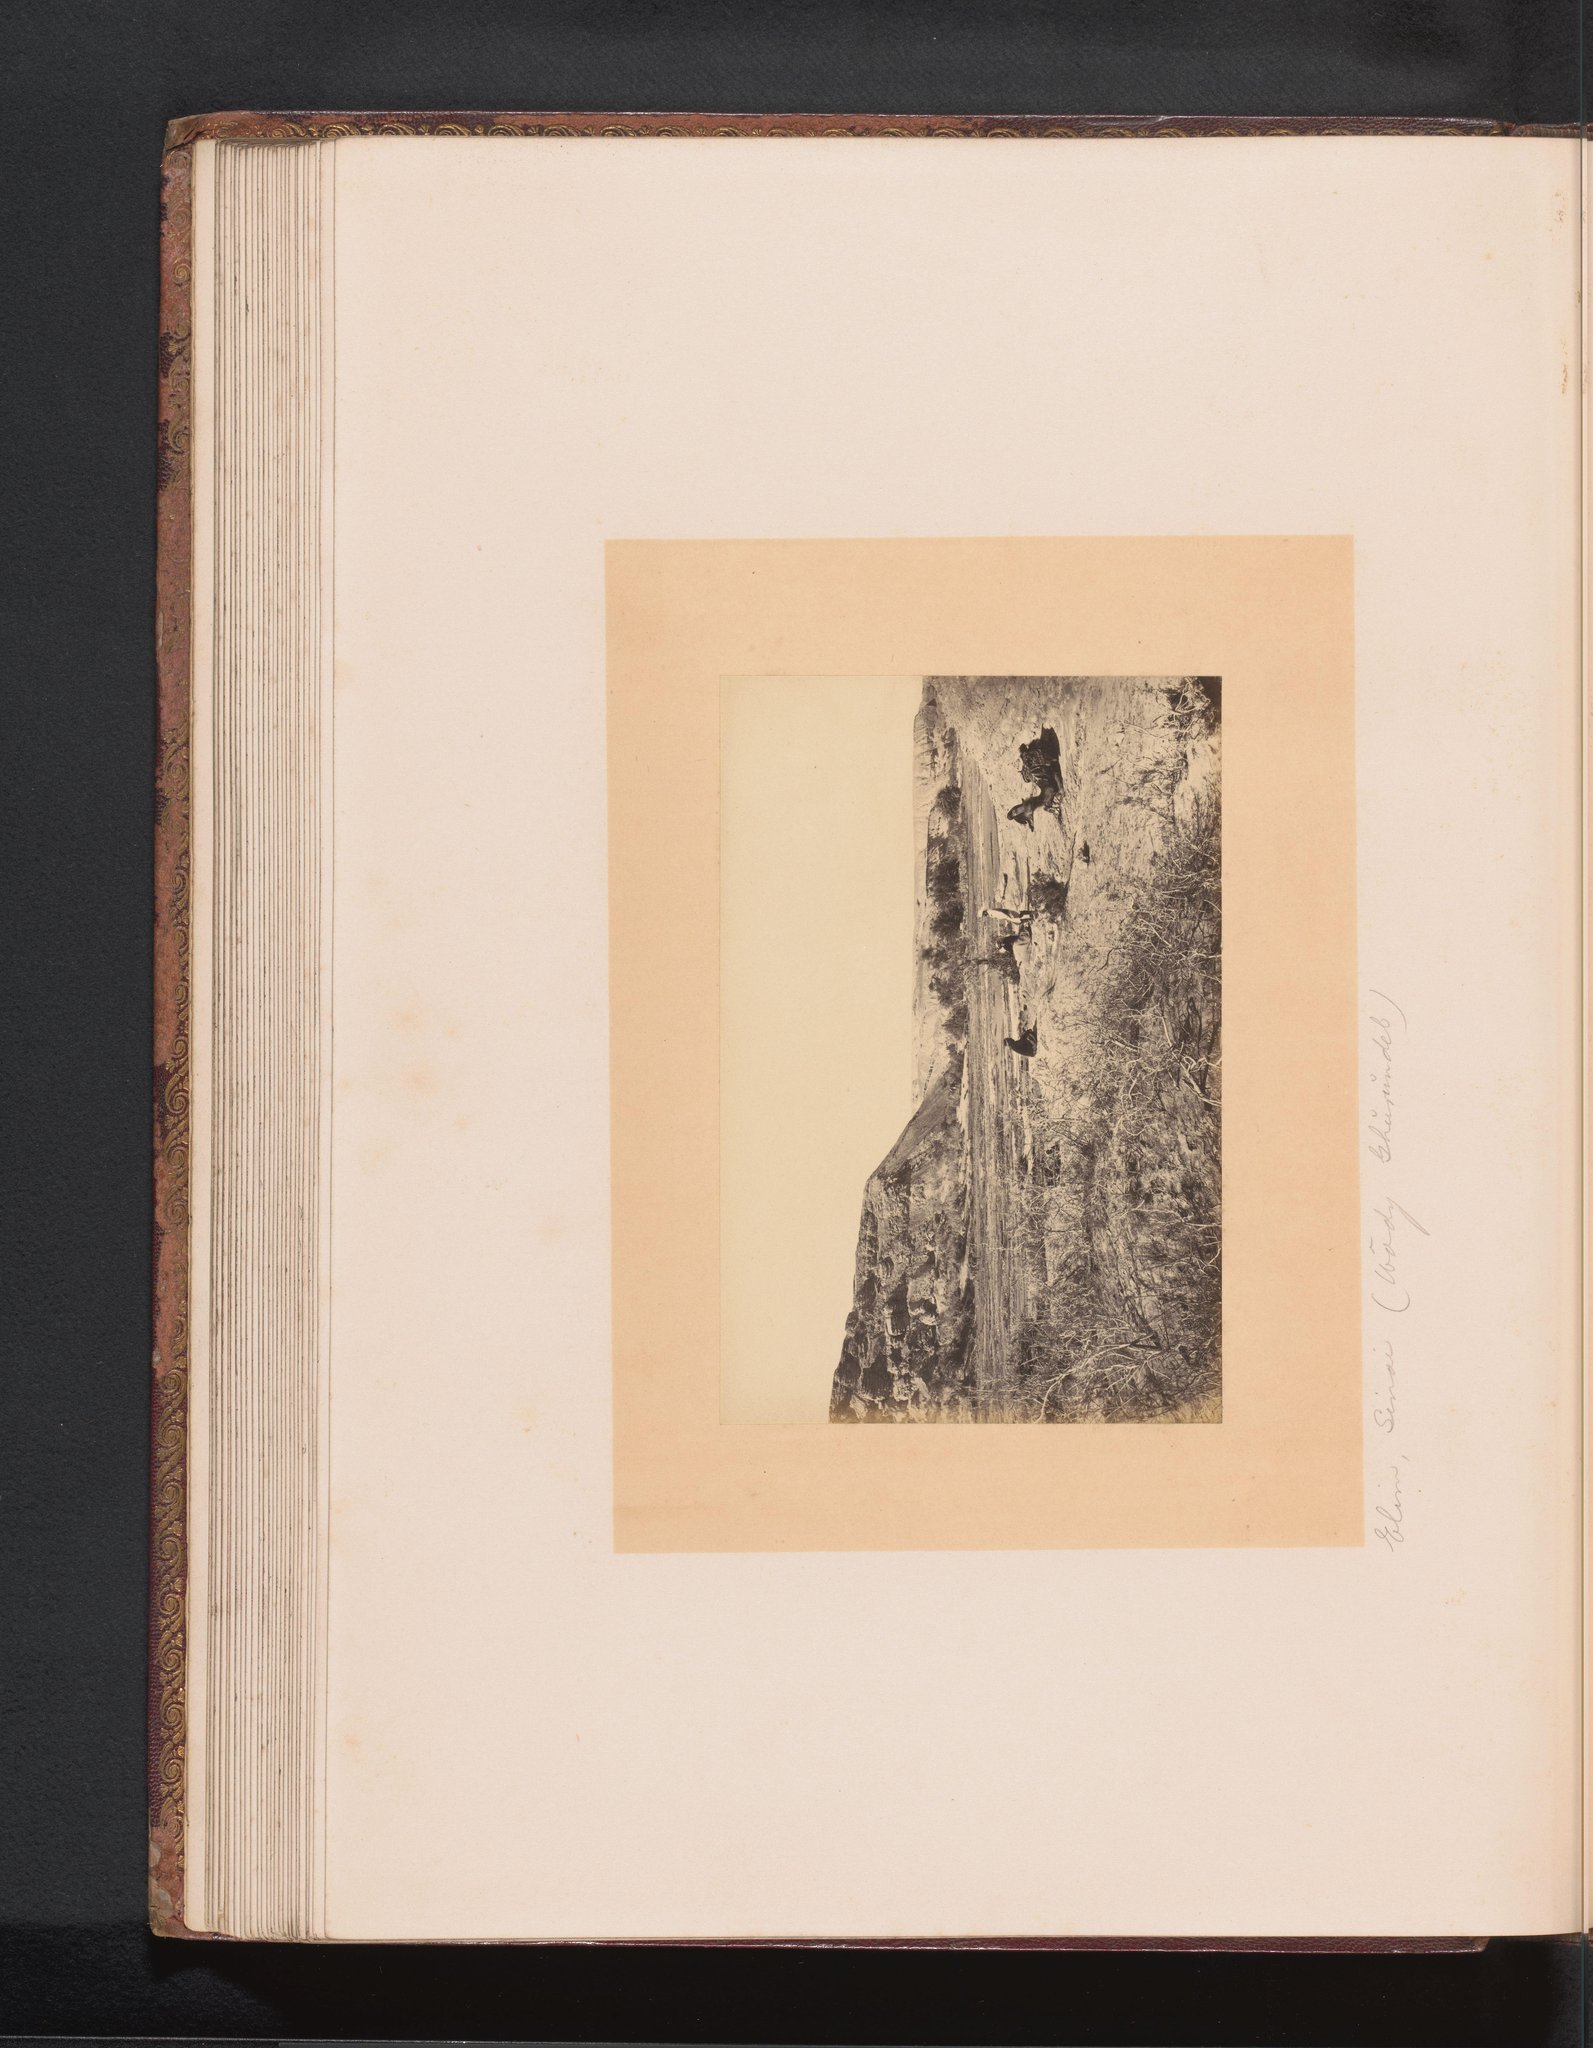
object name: page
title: Gezicht op de oase van Elim te Sinaï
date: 1870-1875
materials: photographic support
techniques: albumen print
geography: sinai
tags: hoofed animals: dromedary, oasis - kk - ideal landscapes (+ landscape (in the non-temperate zone) with figures, staffage)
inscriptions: annotation: ‘Temple of the sun (Baalbek)’